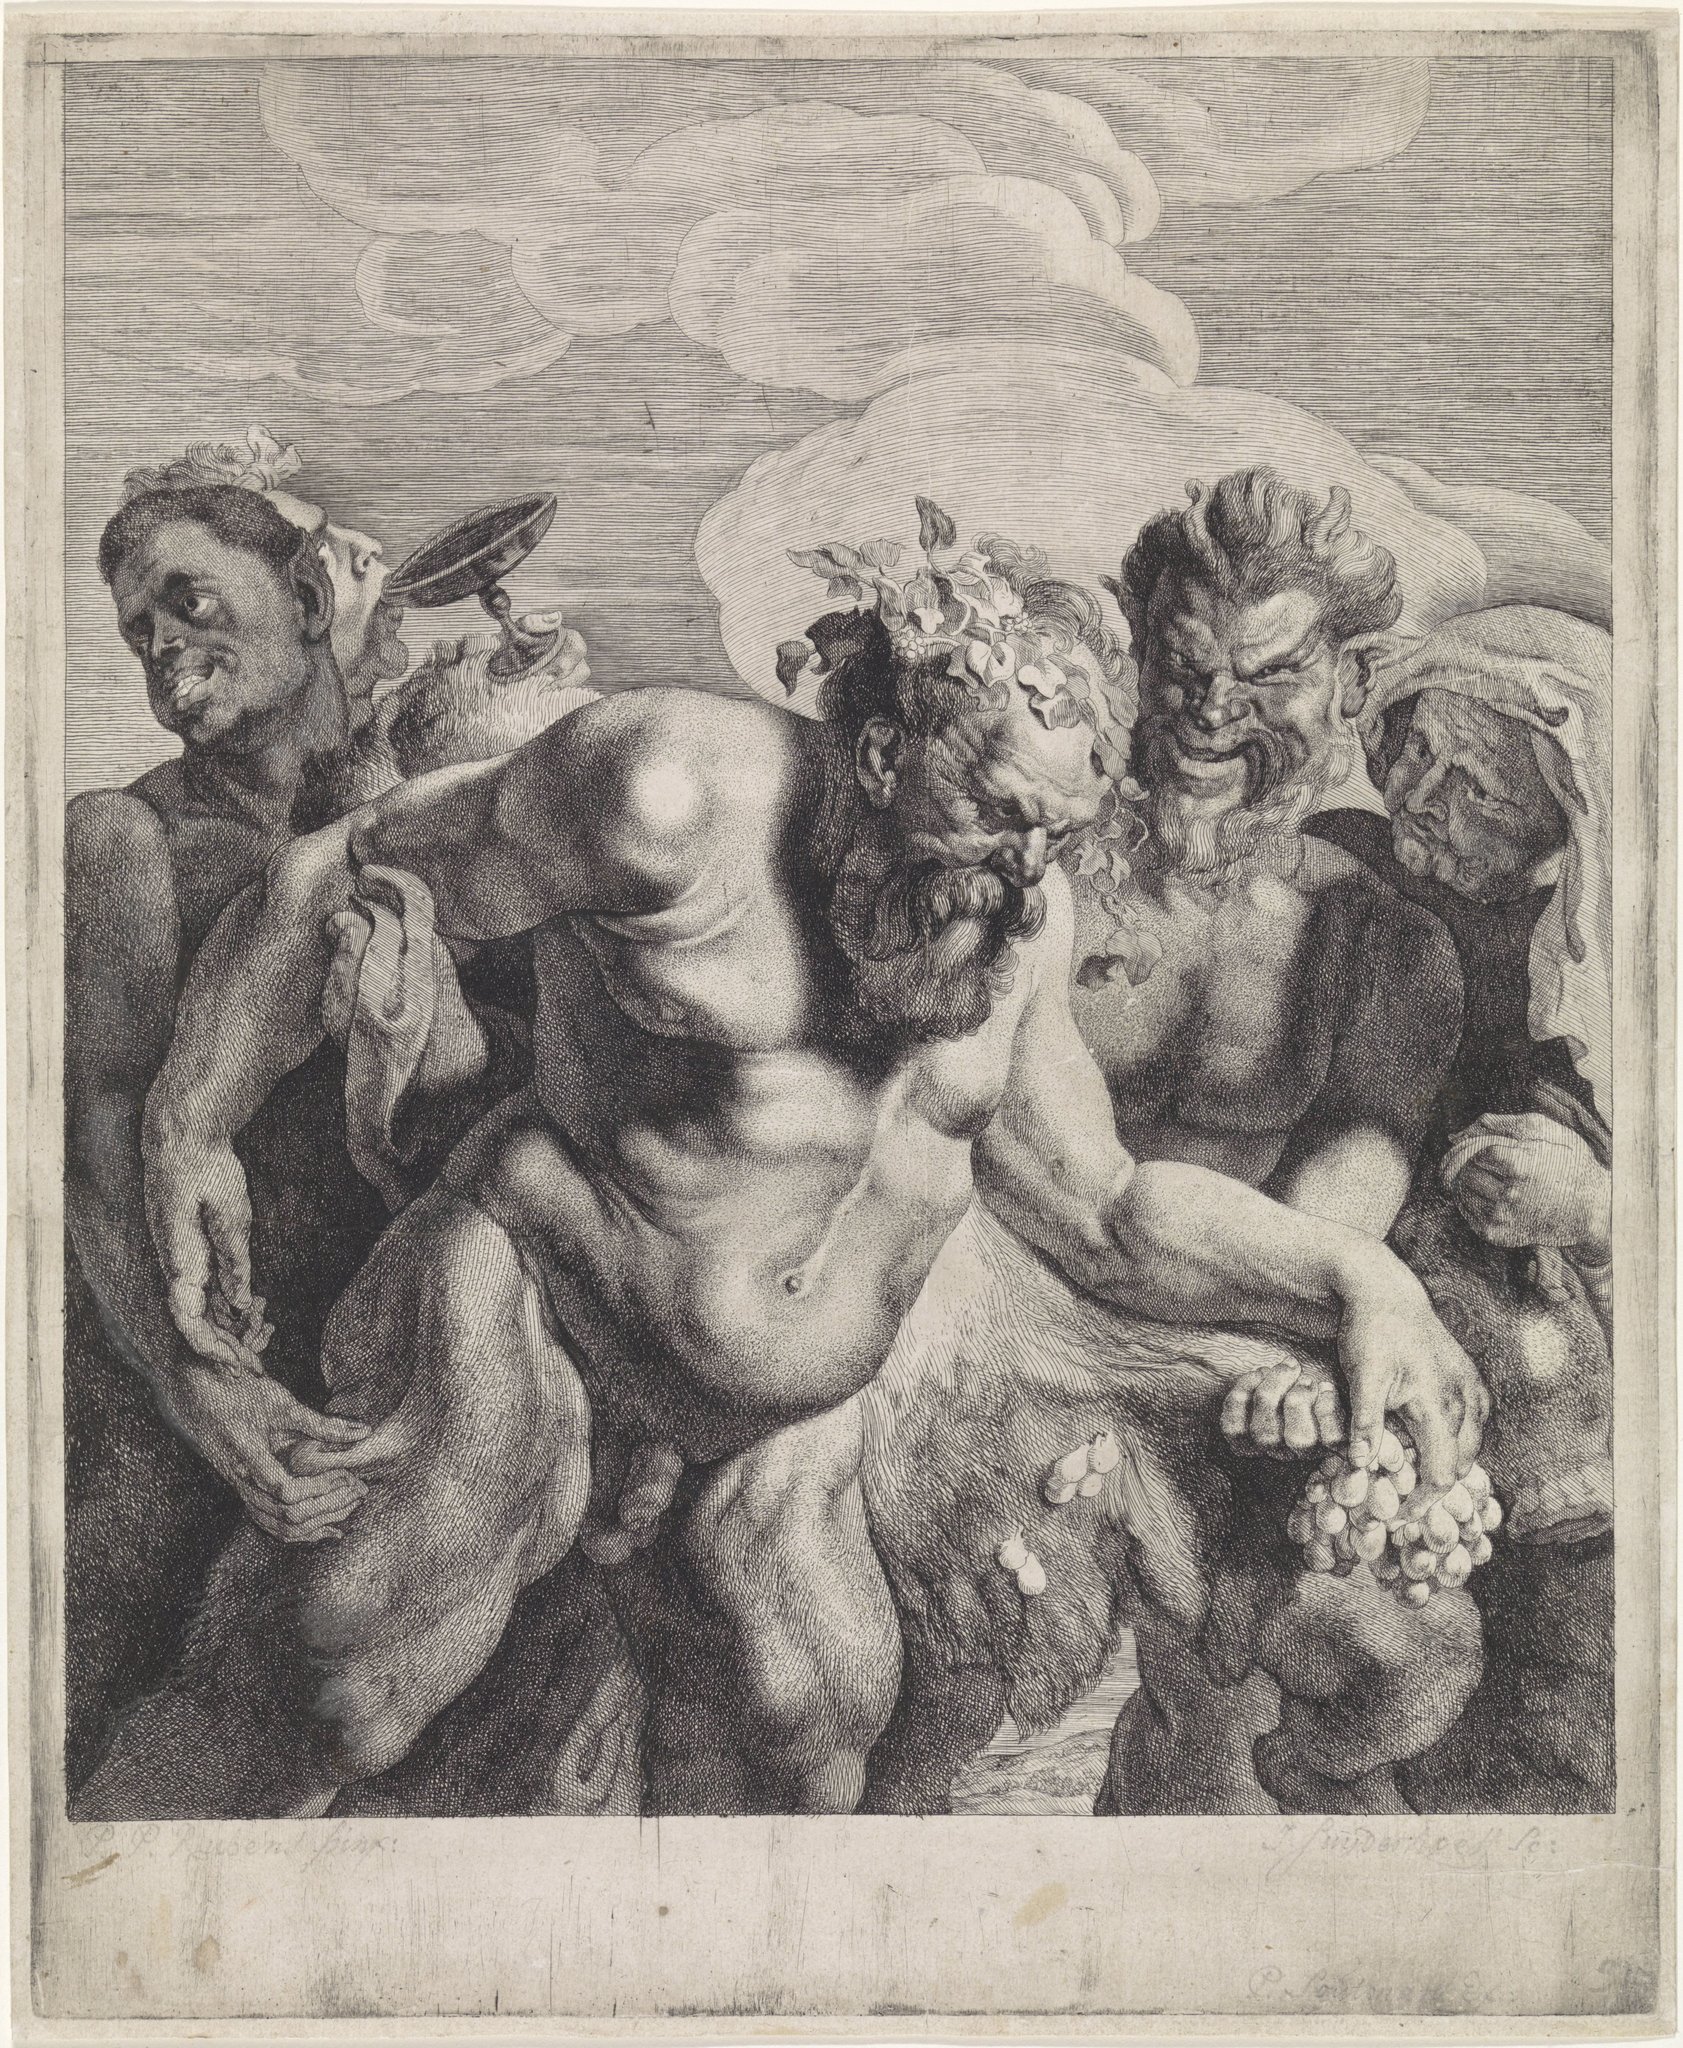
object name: print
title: Dronken Silenus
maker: jonas suyderhoef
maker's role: draughtsman, print maker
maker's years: 1613-1686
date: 1644-1650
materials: paper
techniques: engraving, etching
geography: haarlem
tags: (story of) silenus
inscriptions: collector's mark: Lugt 240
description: De dronken Silenus wordt ondersteund door saters. Silenus heeft een krans van wingerdbladeren op het hoofd.